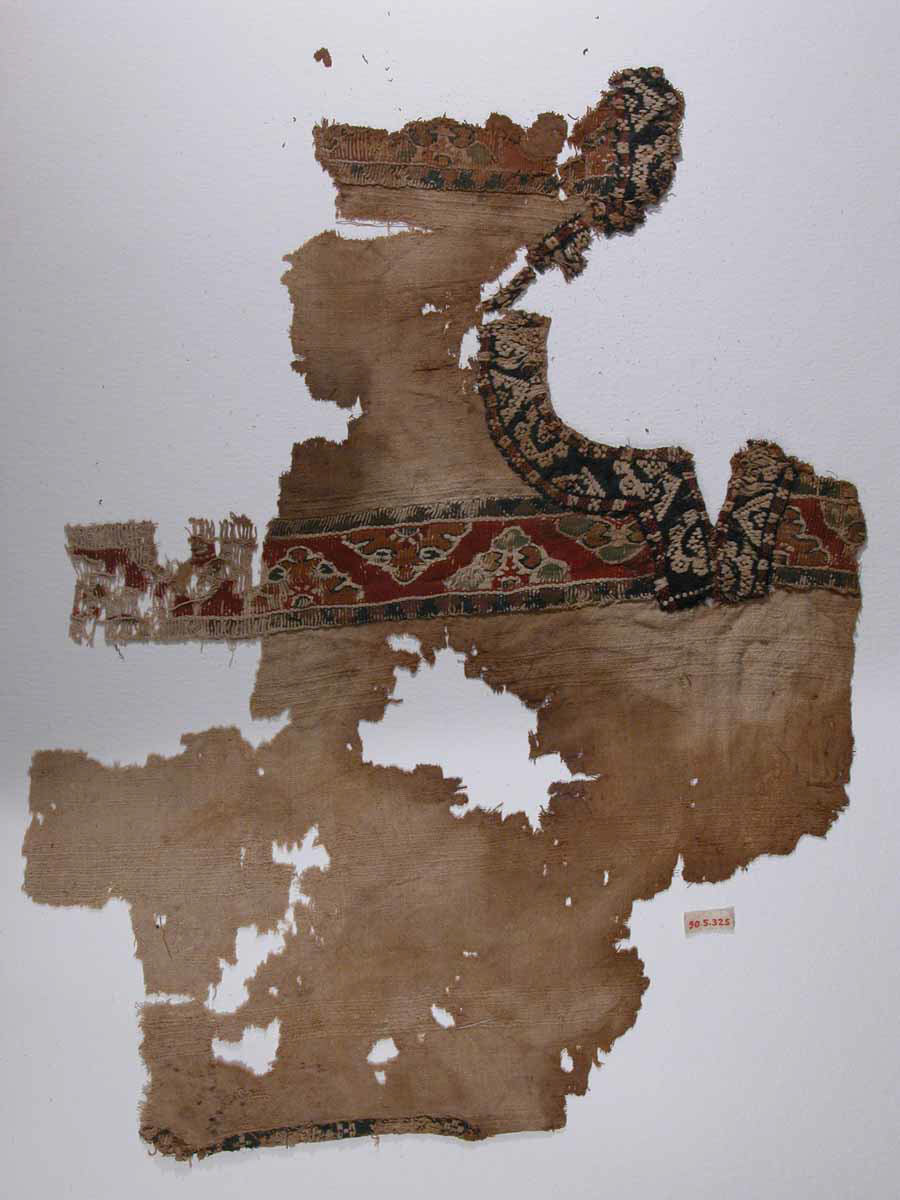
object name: textile fragment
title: Fragment of a Tunic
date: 401-600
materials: linen, wool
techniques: weave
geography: egypt